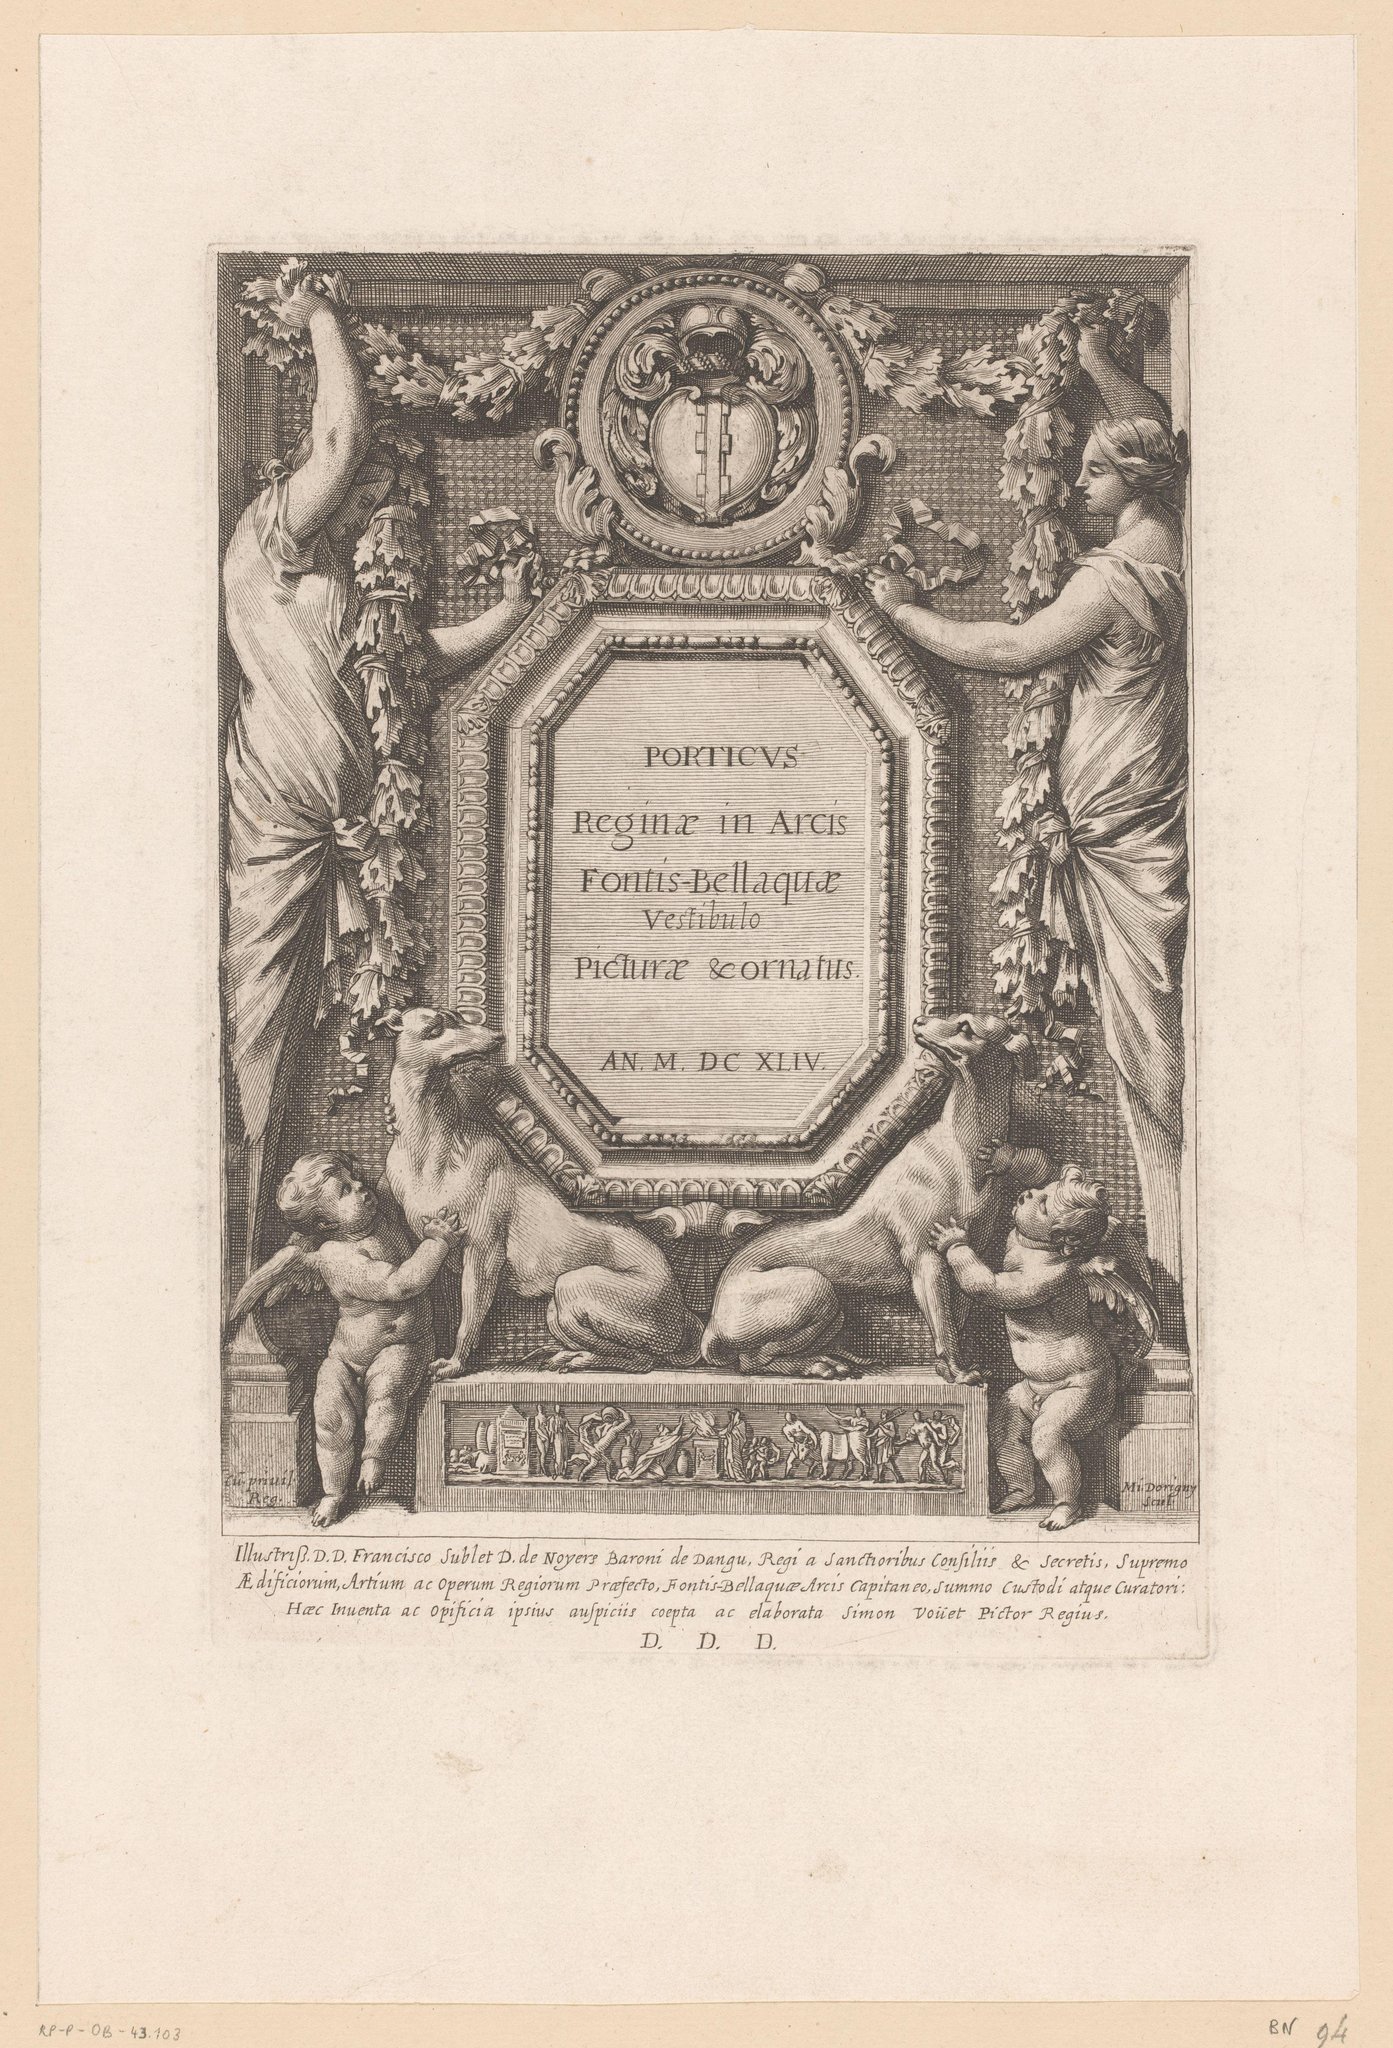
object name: titelprent, frontispice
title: Titelprent met kariatiden, putti en honden in een omlijsting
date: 1644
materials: paper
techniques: engraving, etching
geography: france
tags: caryatids ~ architecture, ornament derived from objects - aa - stylized, cupids: 'amores', 'amoretti', 'putti', dog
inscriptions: collector's mark: Lugt 240